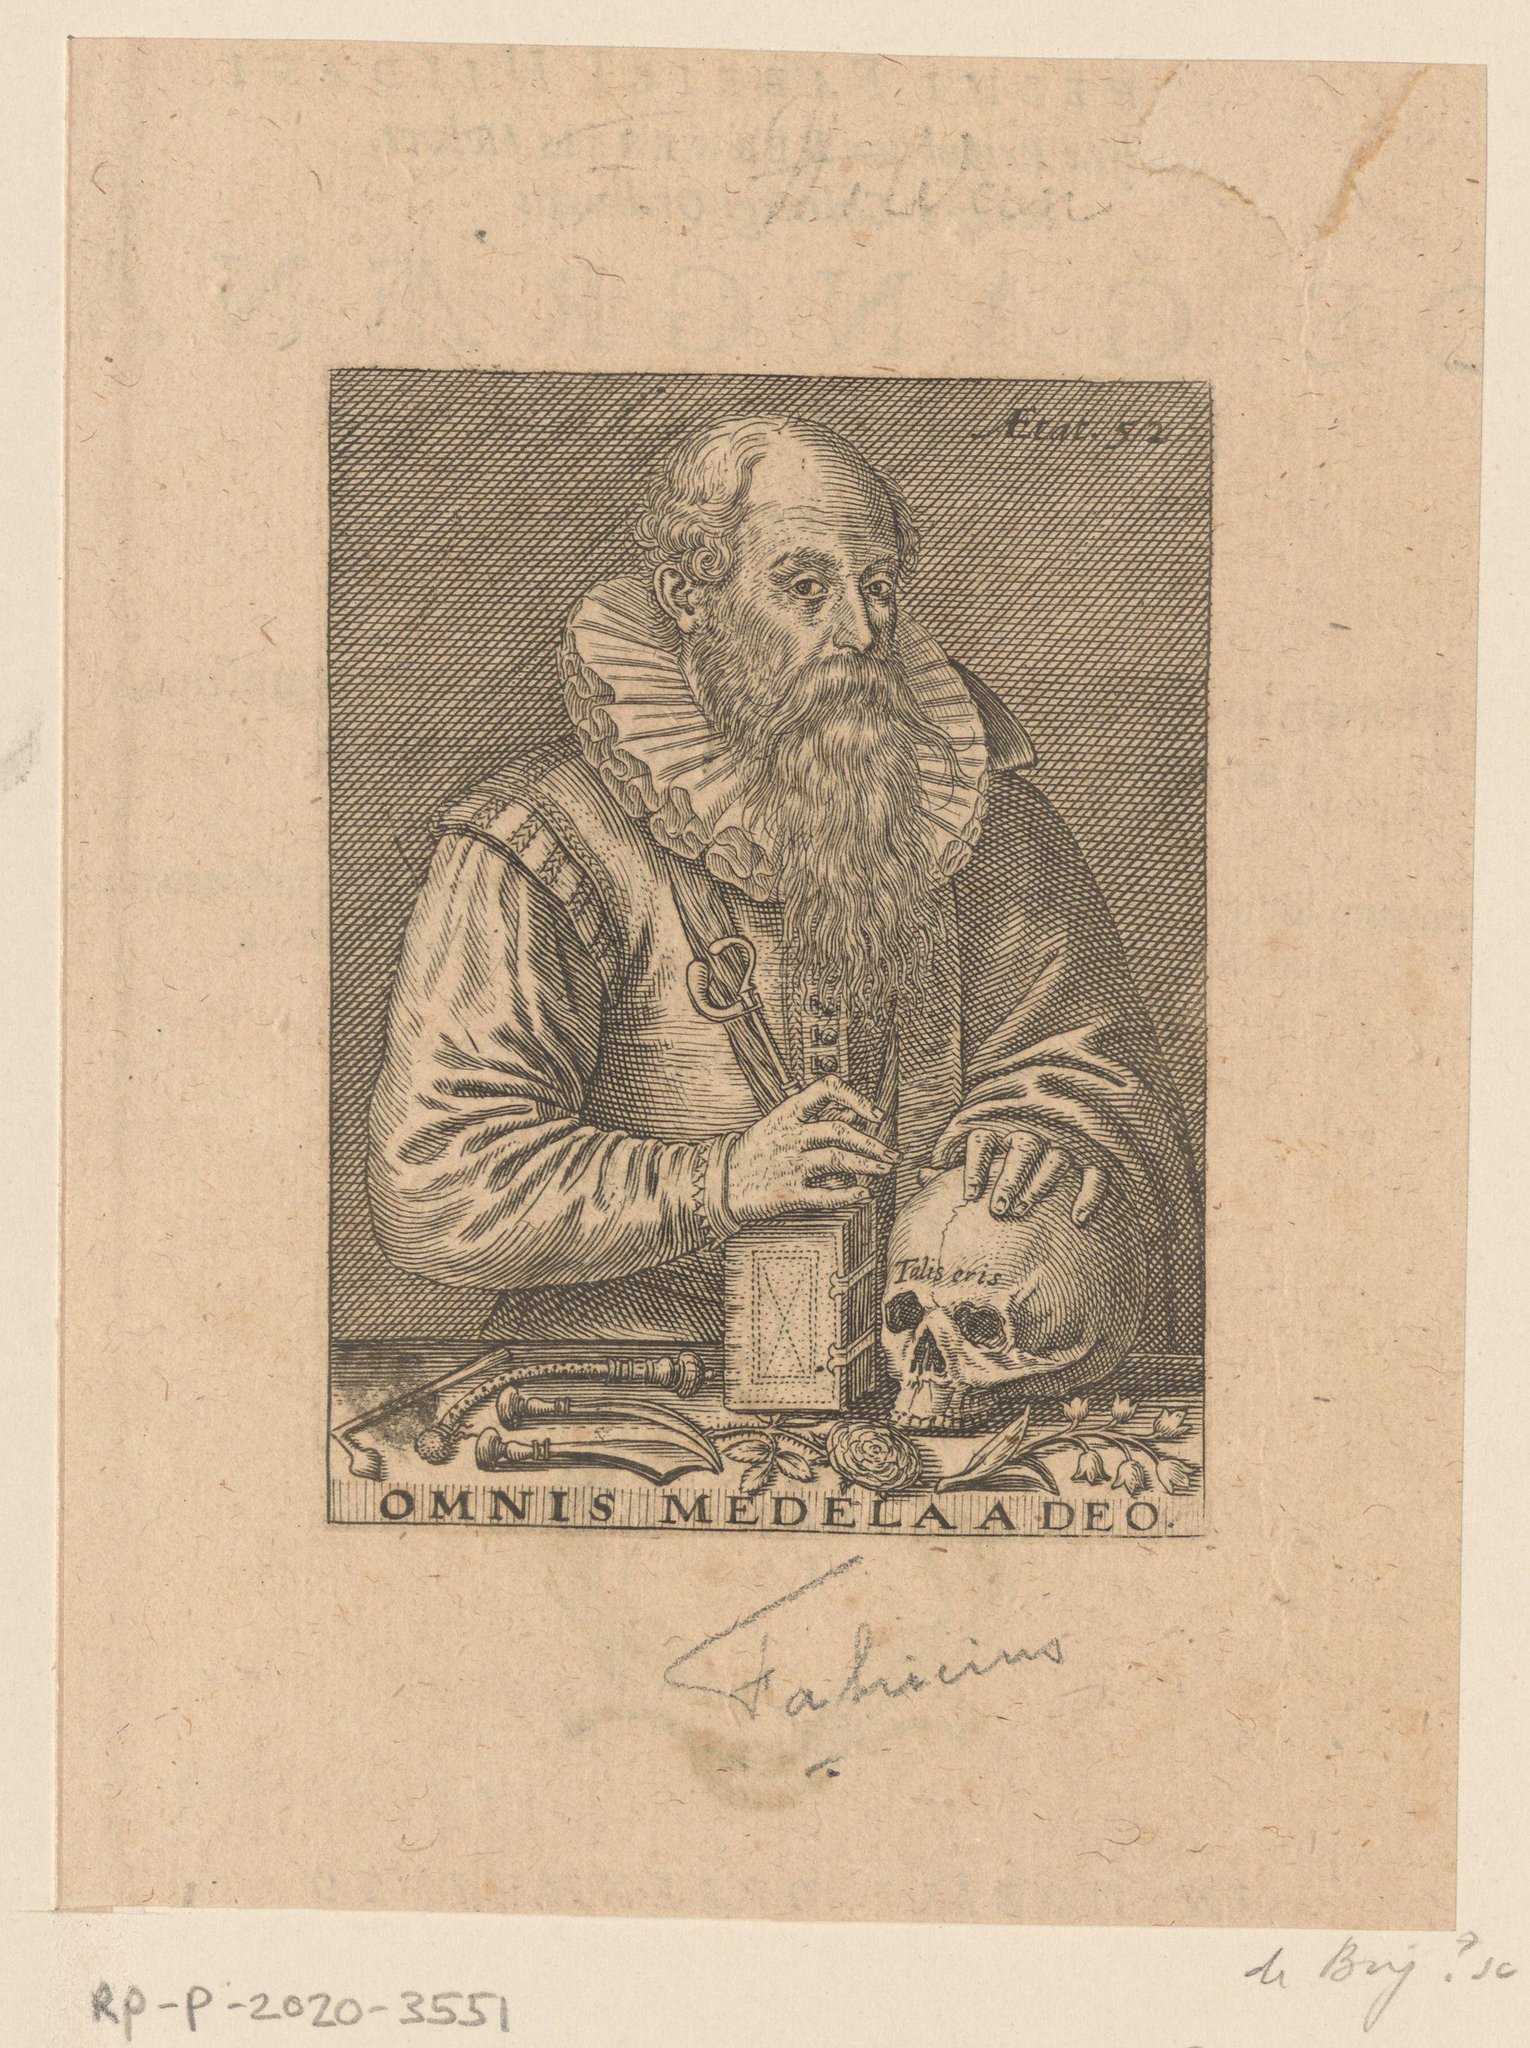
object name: book illustration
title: Portret van Wilhelm Fabry op 52-jarige leeftijd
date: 1617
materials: paper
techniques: engraving, letterpress printing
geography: oppenheim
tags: (human) skull, historical persons, medical instruments, barber; surgeon, book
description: Prent uit: Fabry, Wilhelm. De gangraena et sphacelo (...). Oppenheim: Hieronymus Galler, 1617.